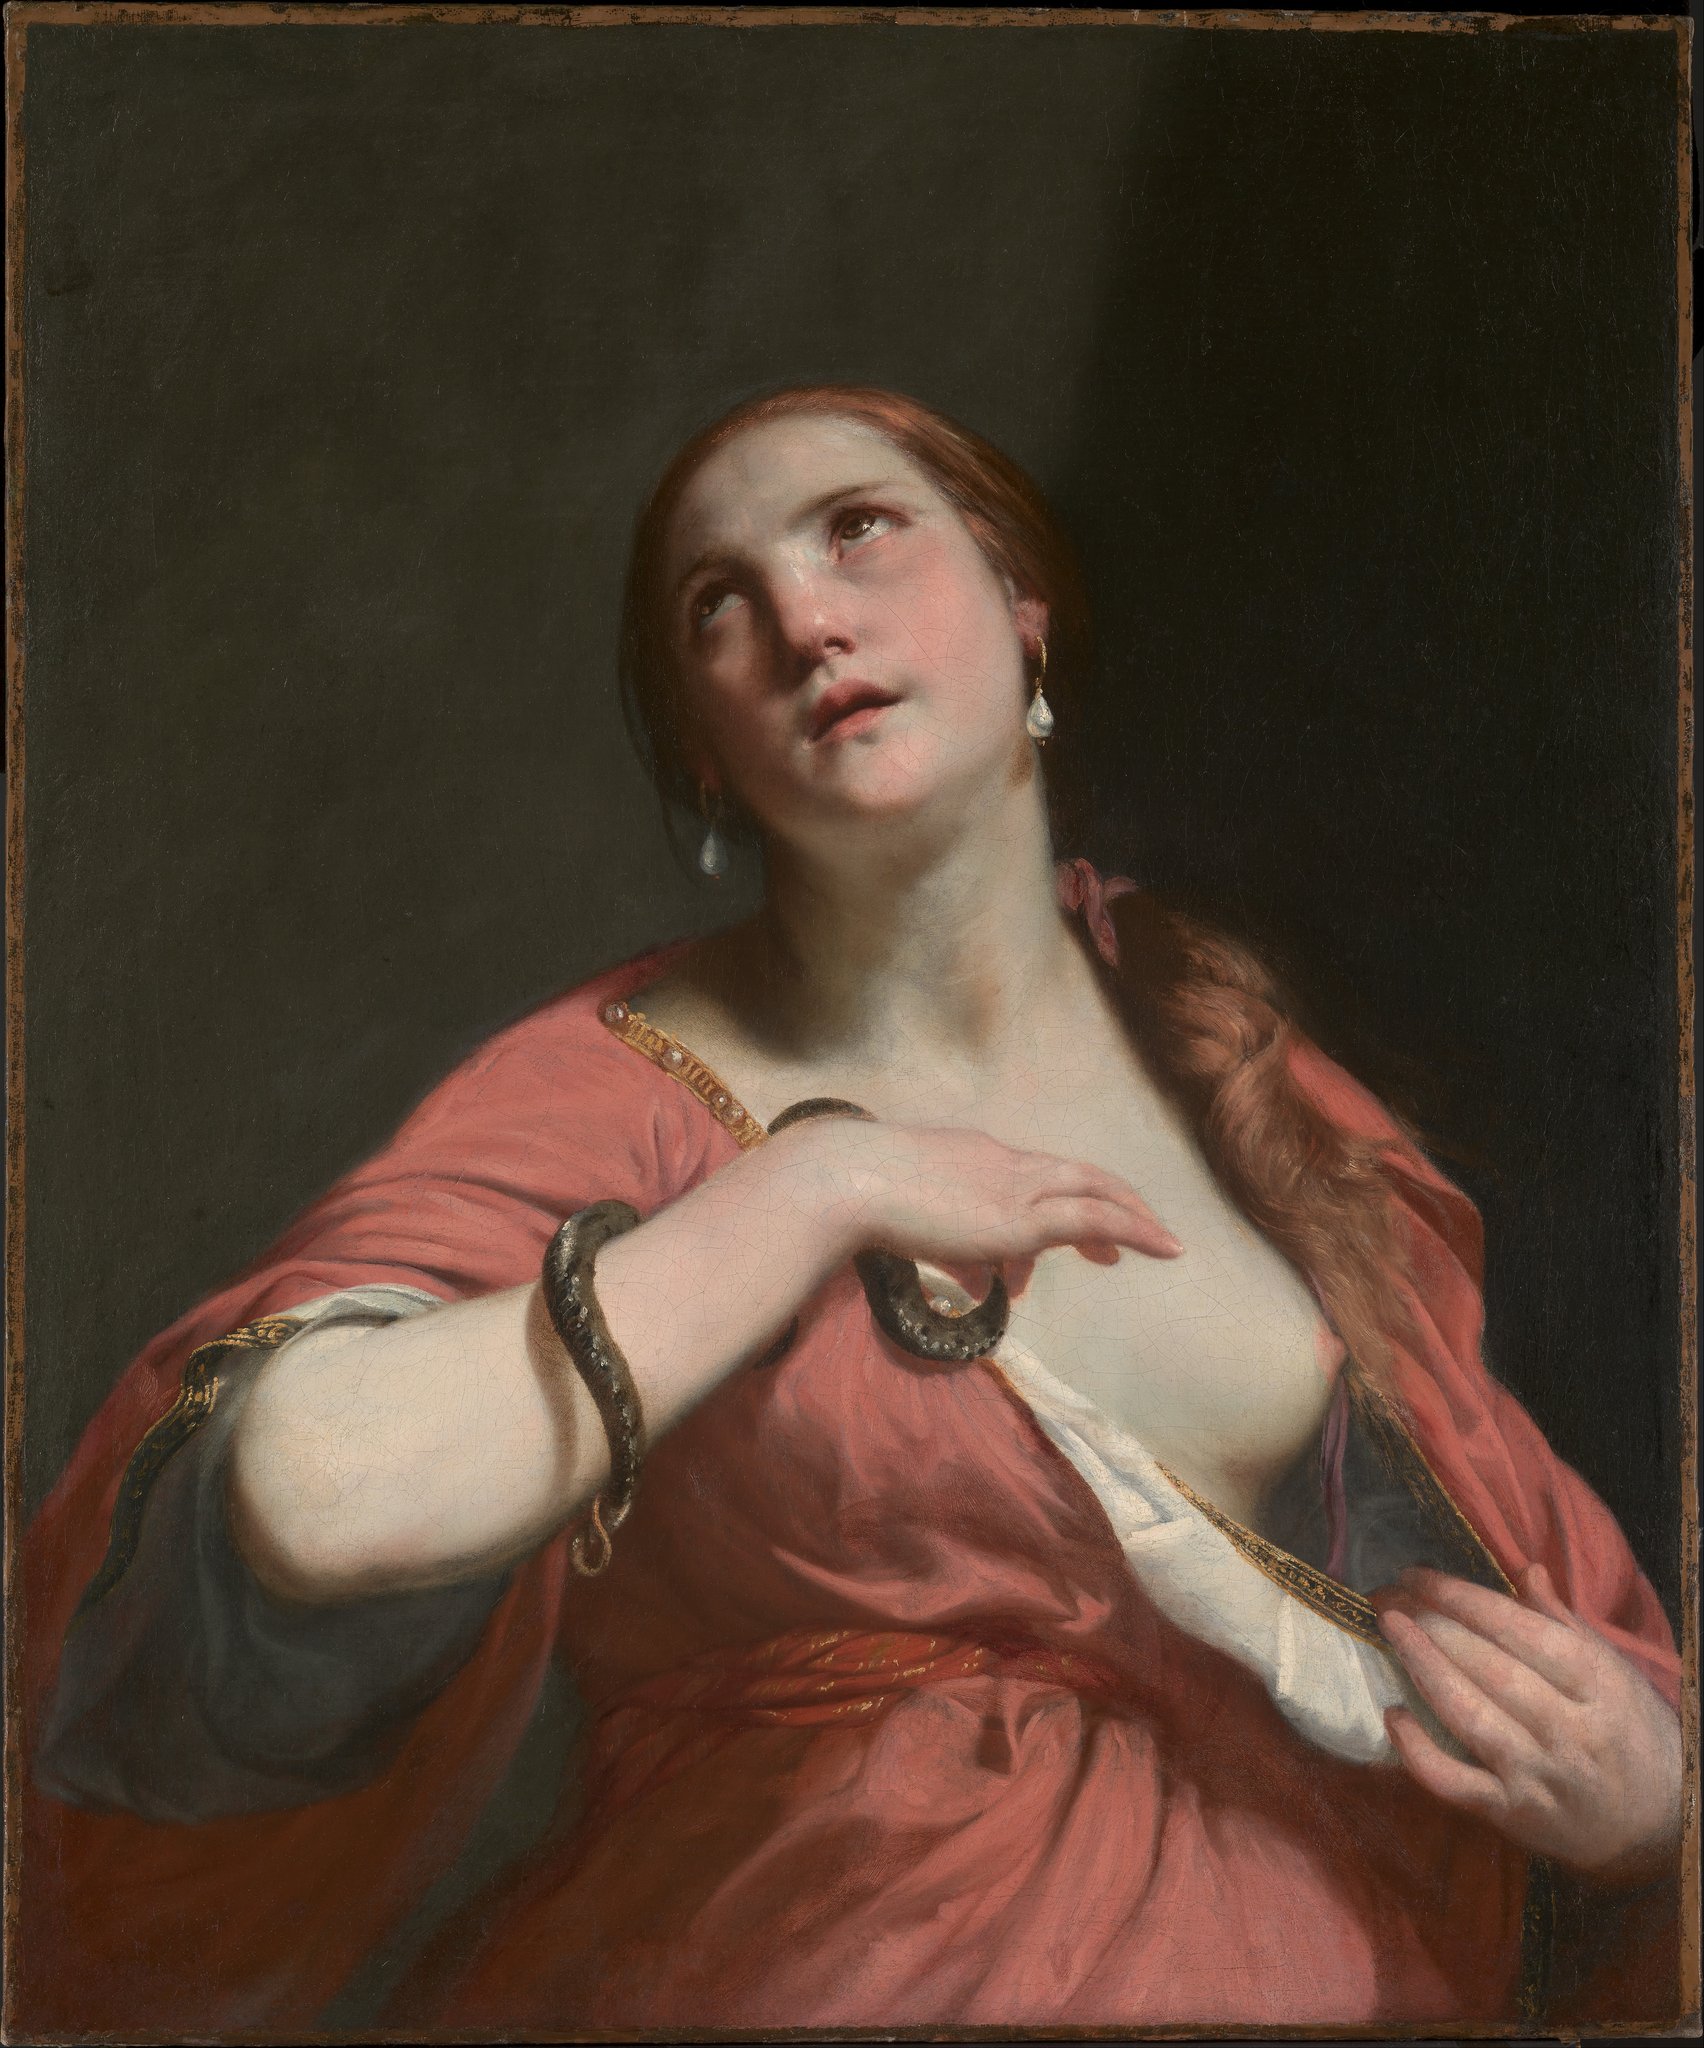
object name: painting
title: The Death of Cleopatra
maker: guido cagnacci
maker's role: artist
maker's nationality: italian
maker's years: 1601-1663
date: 1645-1655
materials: canvas, oil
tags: cleopatra,women,snakes